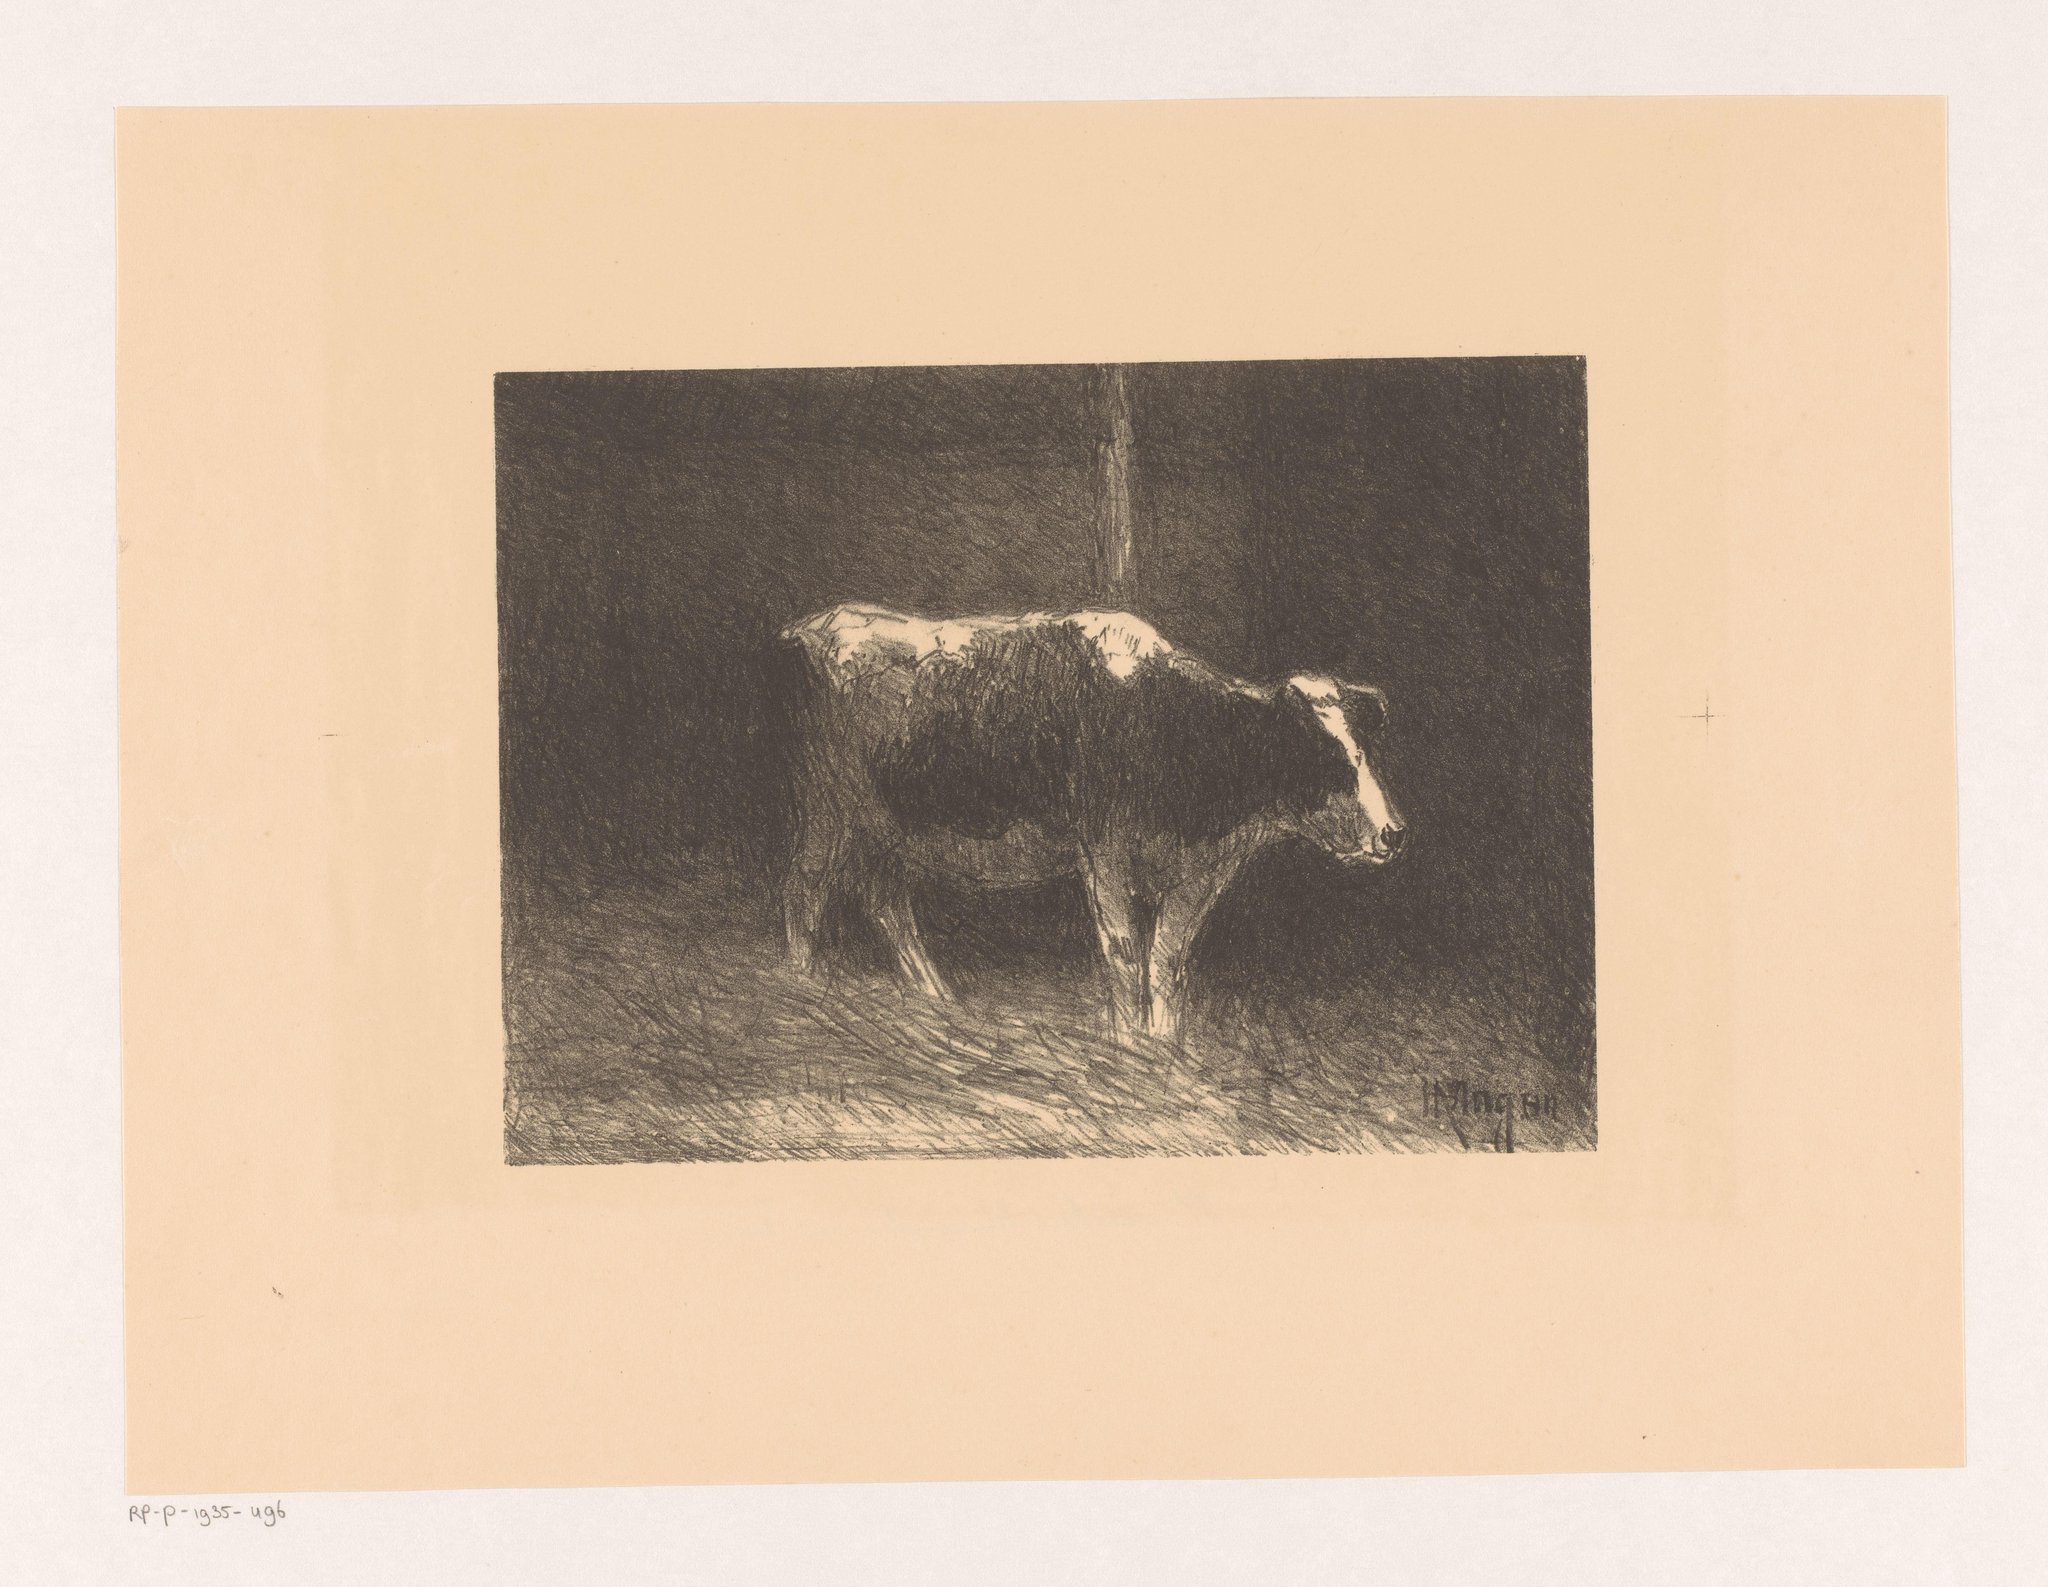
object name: print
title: Koe in stal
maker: hendrikus alexander van ingen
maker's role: draughtsman, print maker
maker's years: 1846-1920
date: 1856-1920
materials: paper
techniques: lithograph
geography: oosterbeek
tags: barn, cow, agricultural products and by-products: straw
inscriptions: collector's mark: Lugt 2228, collector's mark: Lugt 2760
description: De koe staat in een donkere stal met licht van boven. Op de grond ligt stro.